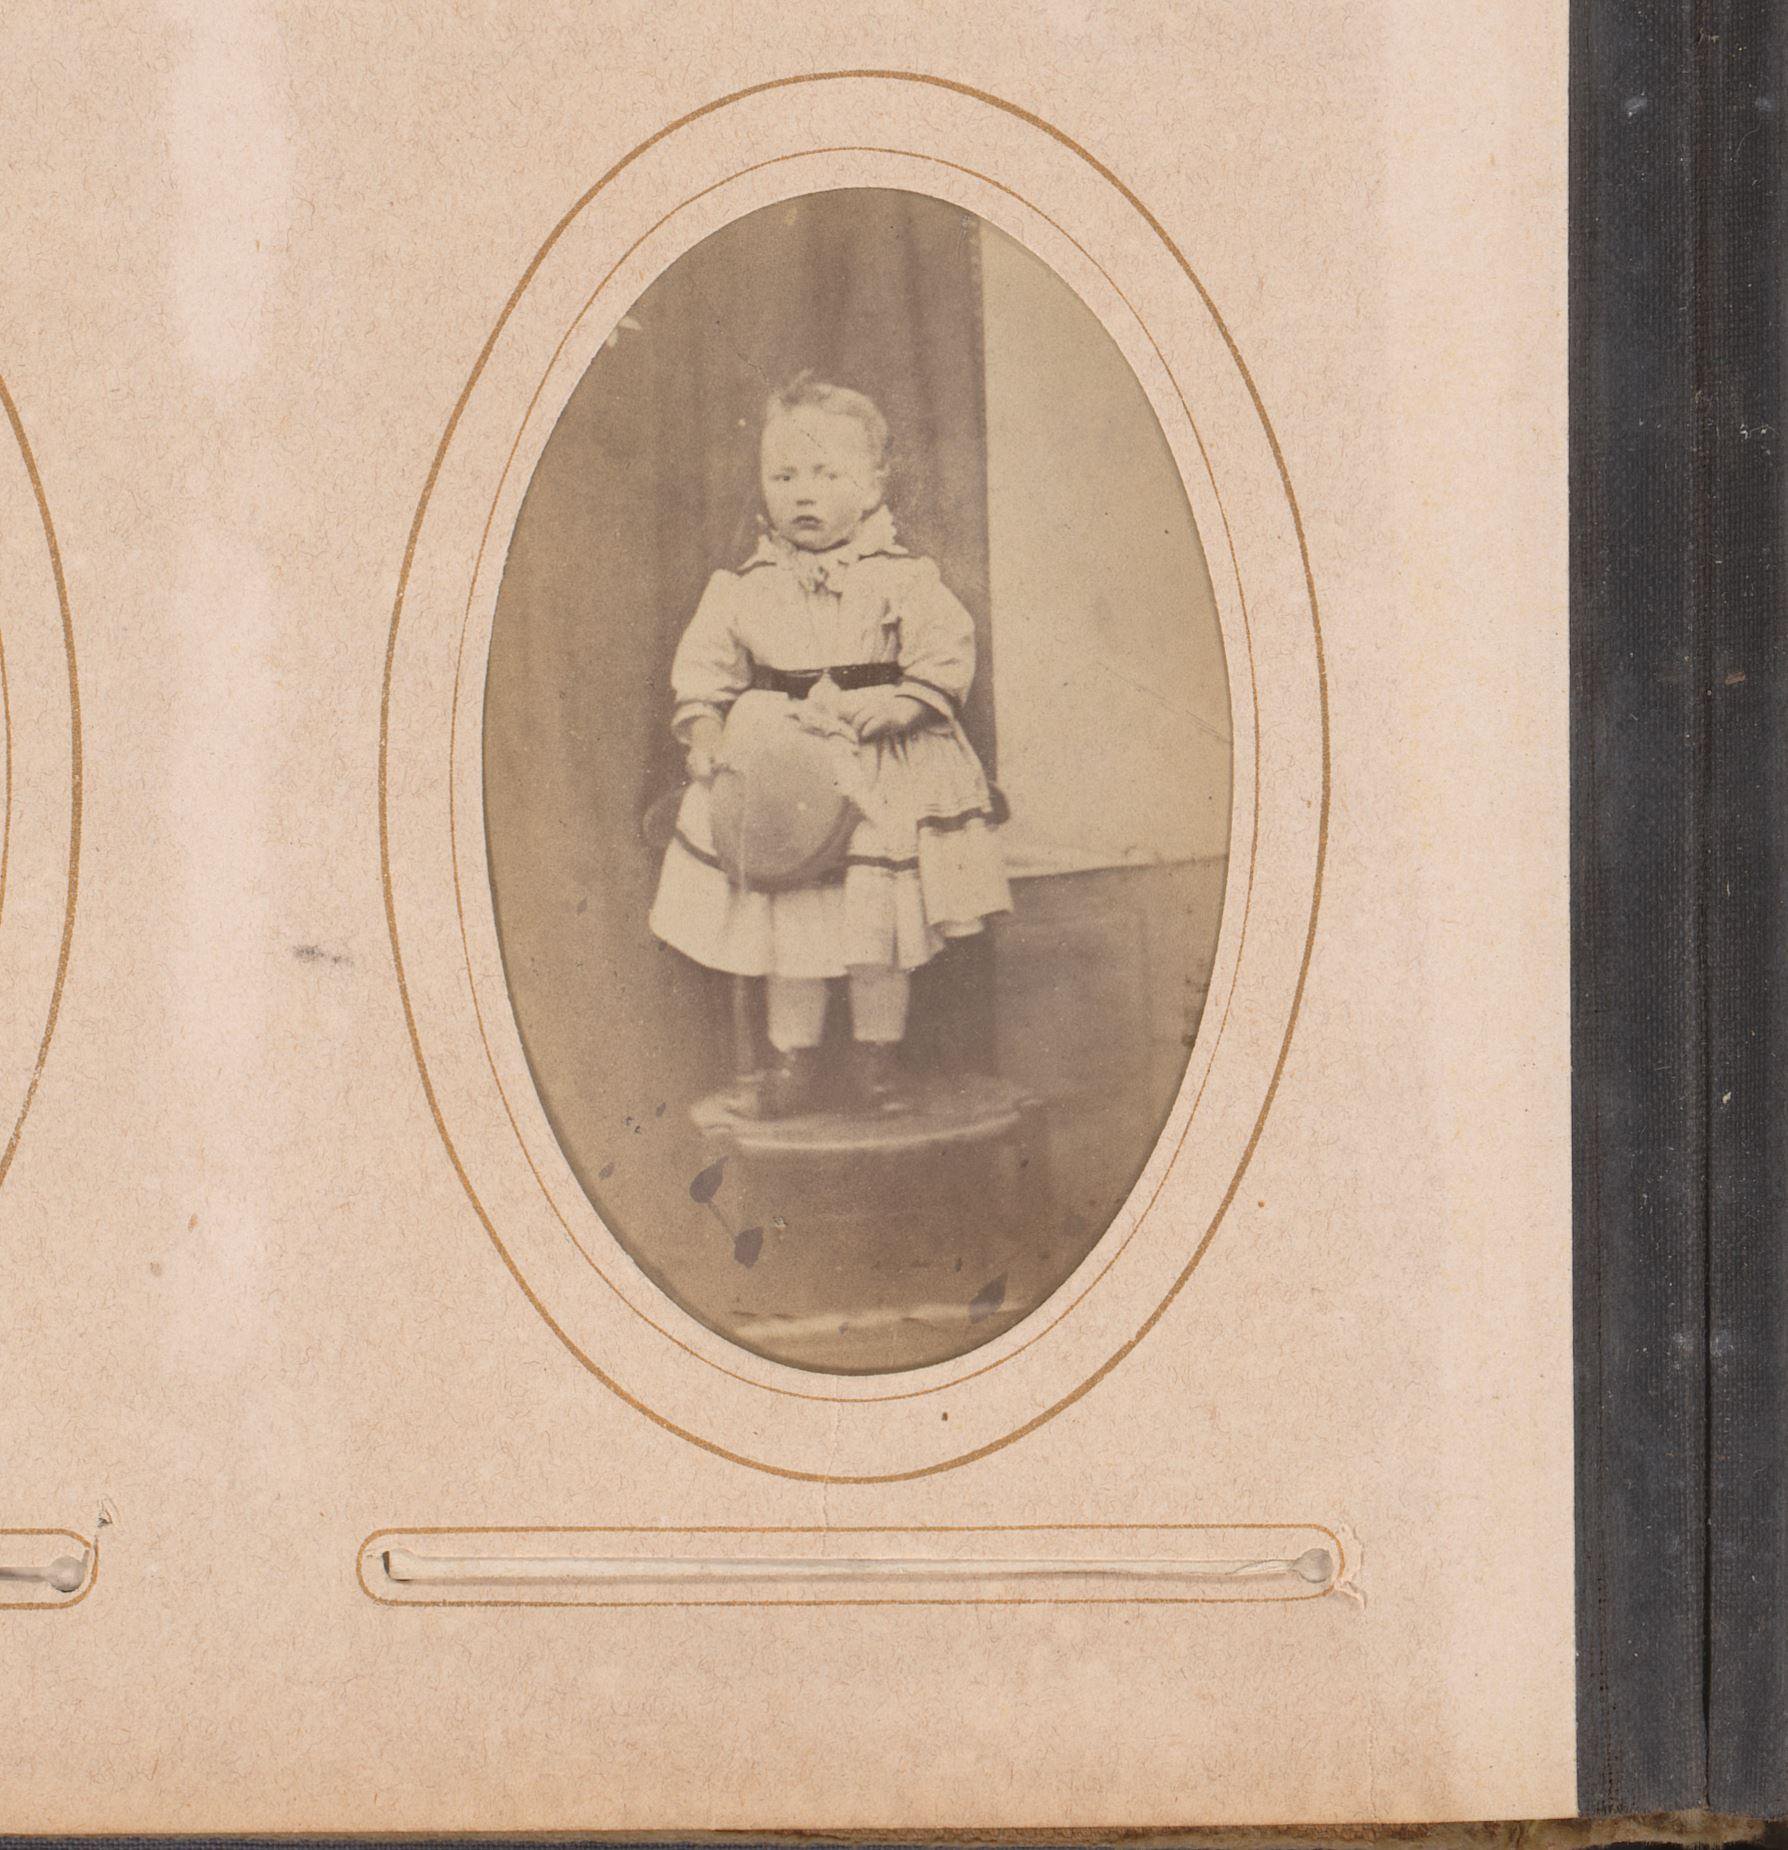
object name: album leaf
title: Portret van een meisje met hoed, staand op een stoel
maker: franz wilhelm deutmann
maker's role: fotograaf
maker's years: 1809-1895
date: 1860-1890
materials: cardboard, photographic support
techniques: albumen print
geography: netherlands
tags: girl (child between toddler and youth), head-gear: hat, standing figure - aa - female human figure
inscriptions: inscription: ‘Réproduction/ F.W. Deutmann/ Phot’